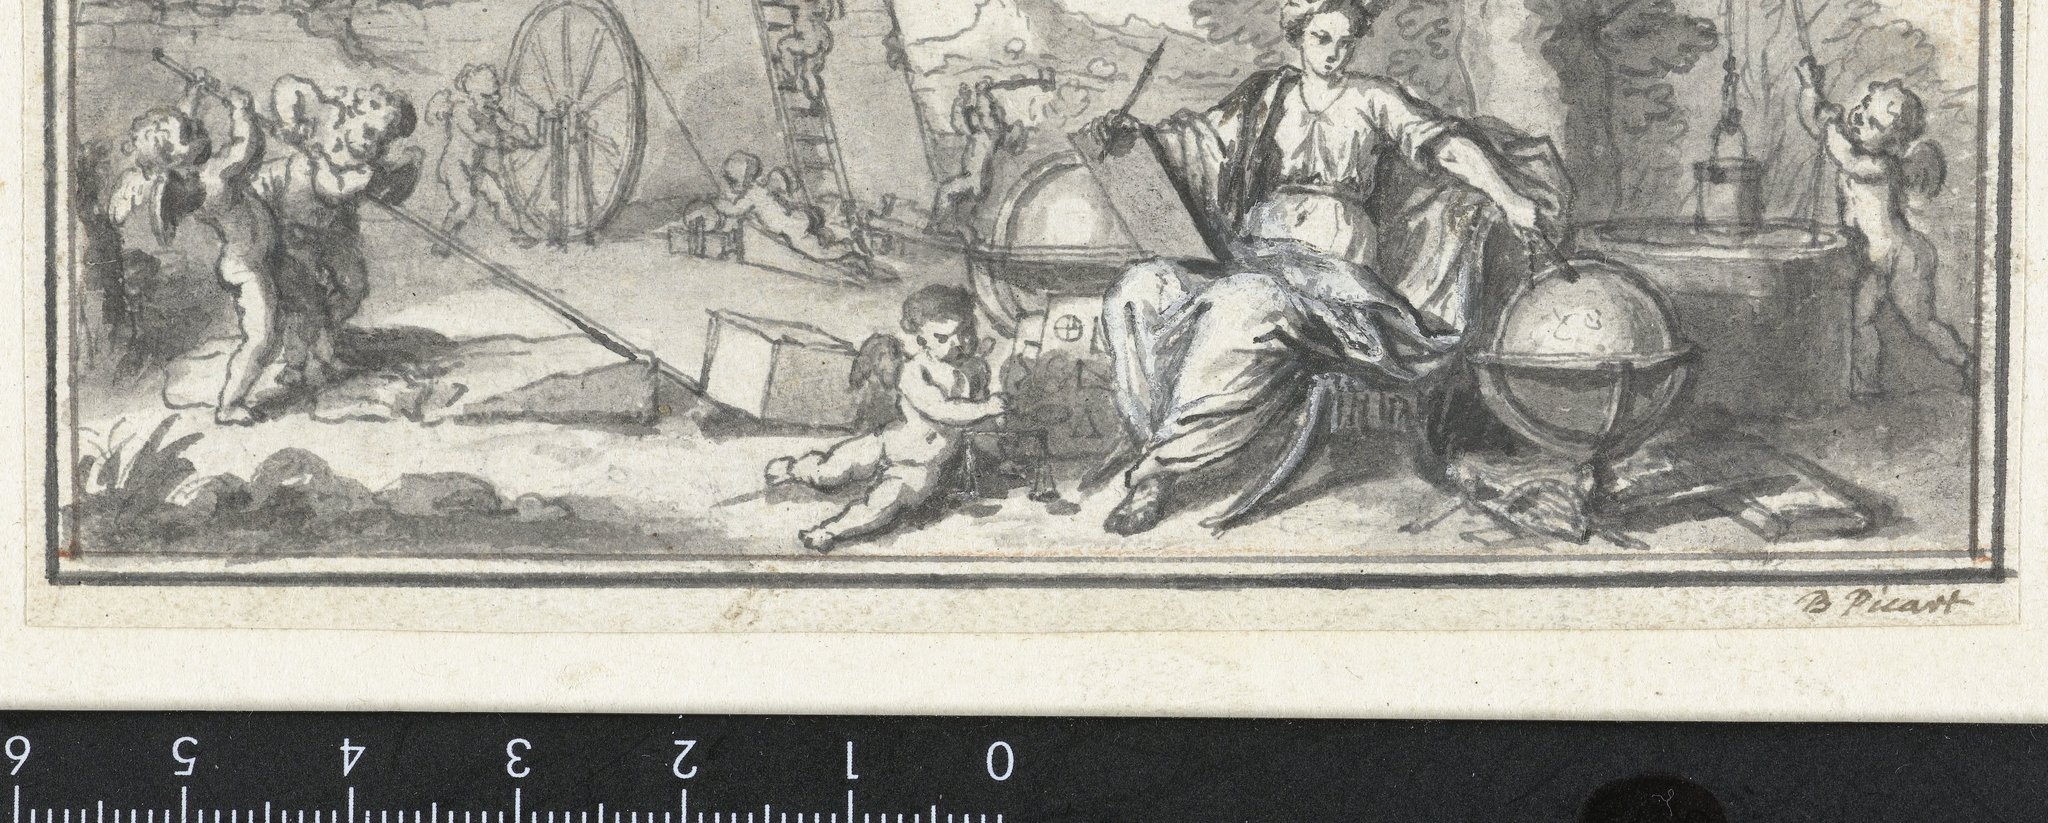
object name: drawing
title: Allegorie op de Wetenschappen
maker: bernard picart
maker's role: draughtsman, print maker, publisher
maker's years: 1673-1733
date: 1683-1733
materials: paint, ink, paper, pencil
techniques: brush, pen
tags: science and technology